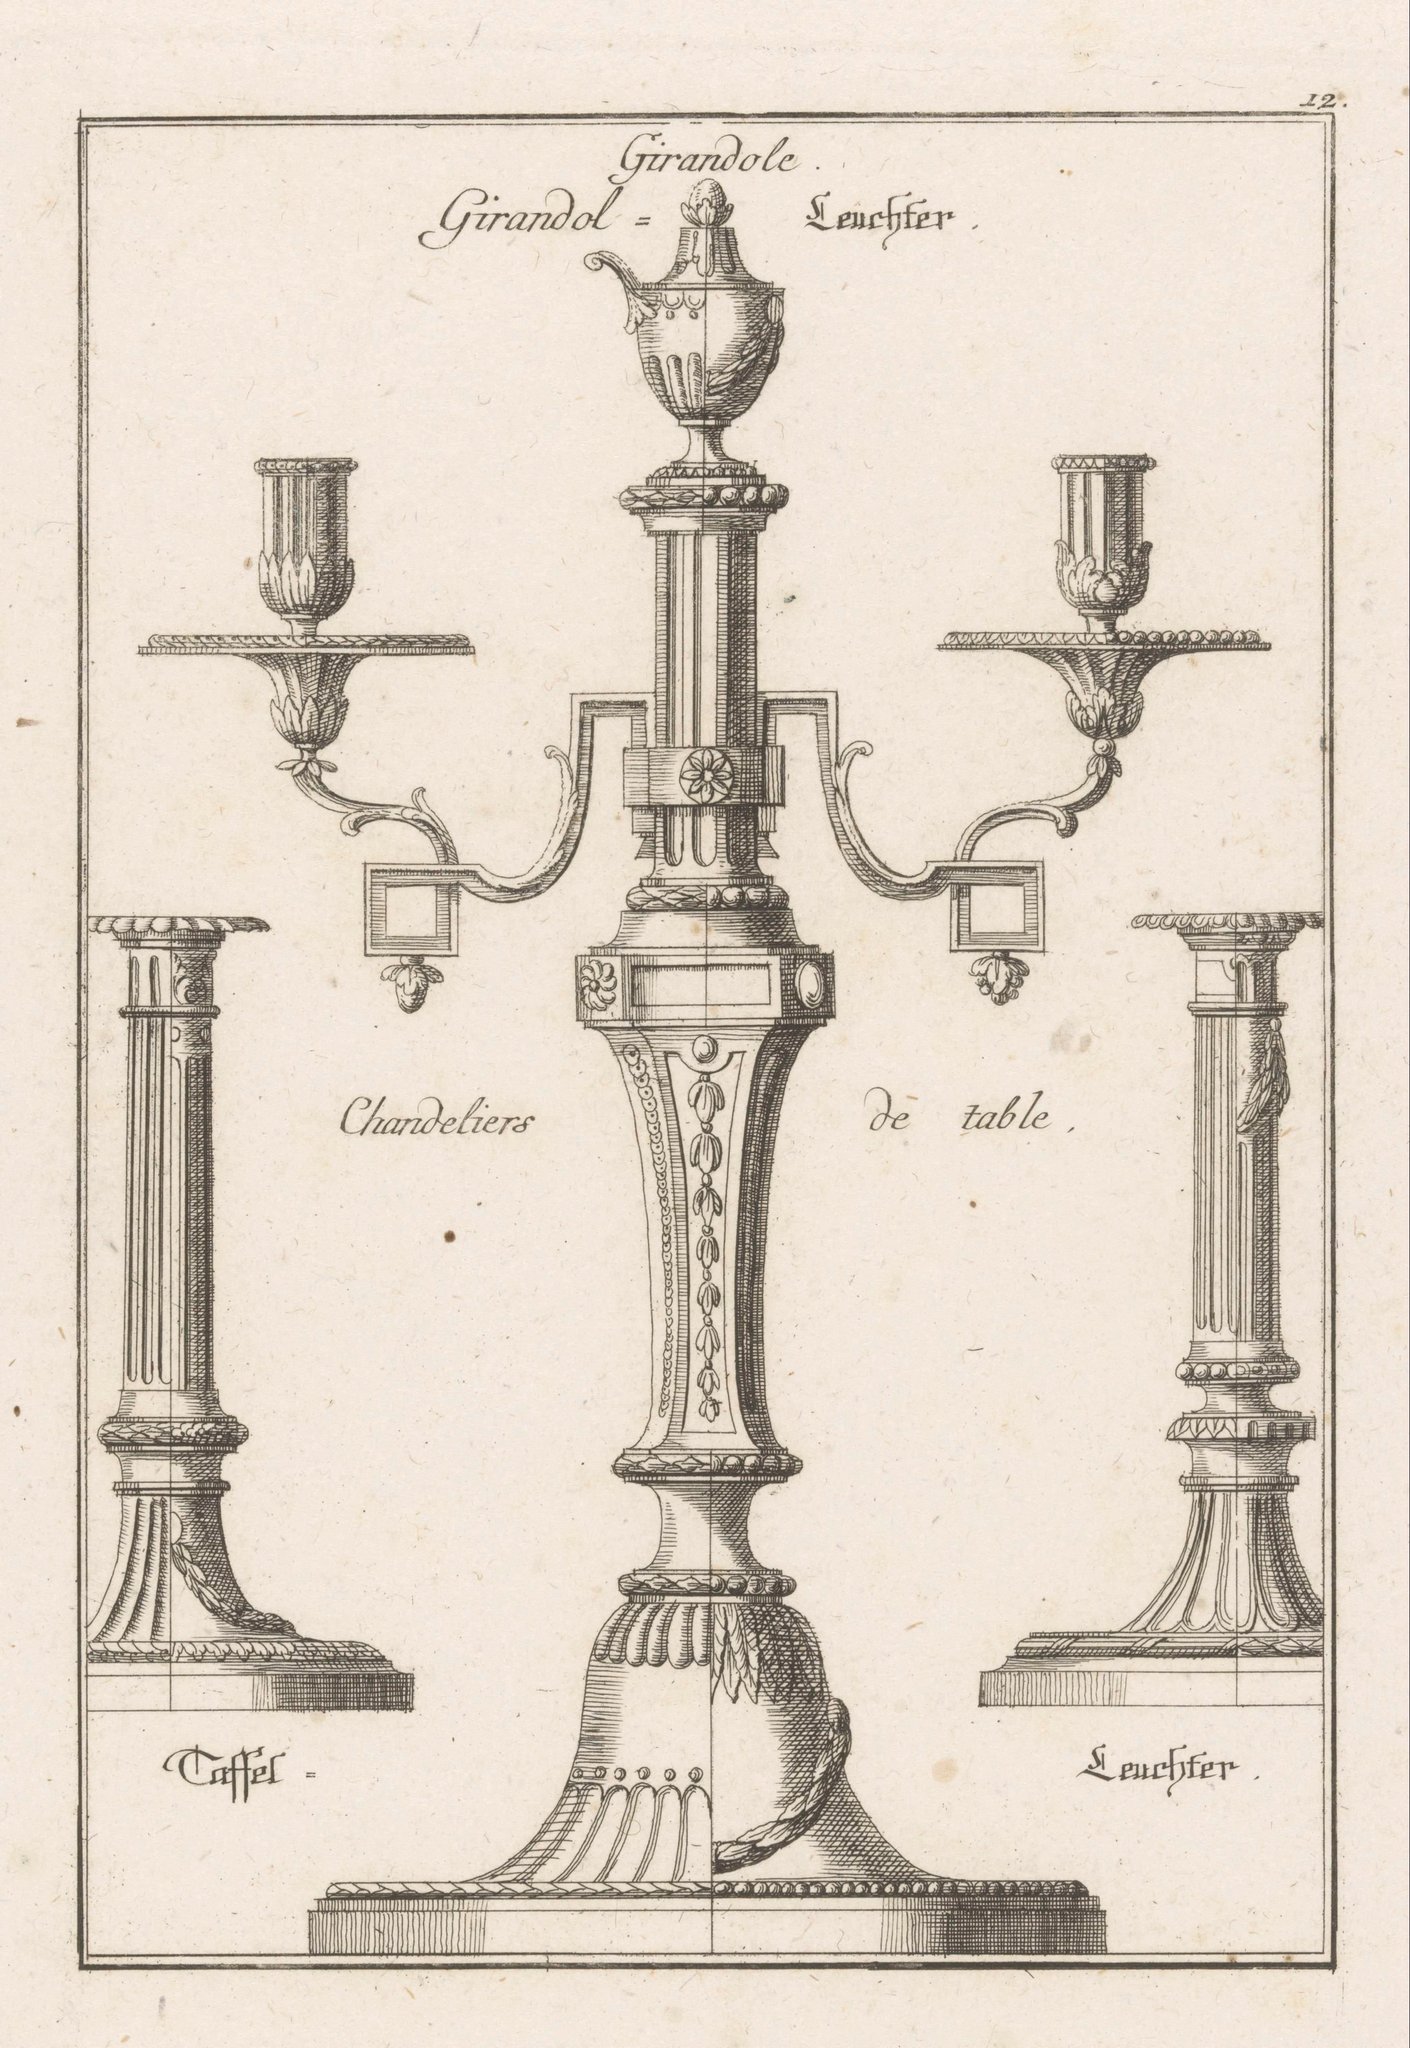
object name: print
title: Ontwerpen van zilverwerk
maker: franz xaver habermann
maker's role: draughtsman, print maker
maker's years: 1721-1796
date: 1731-1796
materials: paper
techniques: etching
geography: germany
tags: chandelier, candelabrum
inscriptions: collector's mark: Lugt 2760, collector's mark: Lugt 2228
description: Twee tafelkandelaars en een driearmige girandole, met bladmotieven en ornamenten.